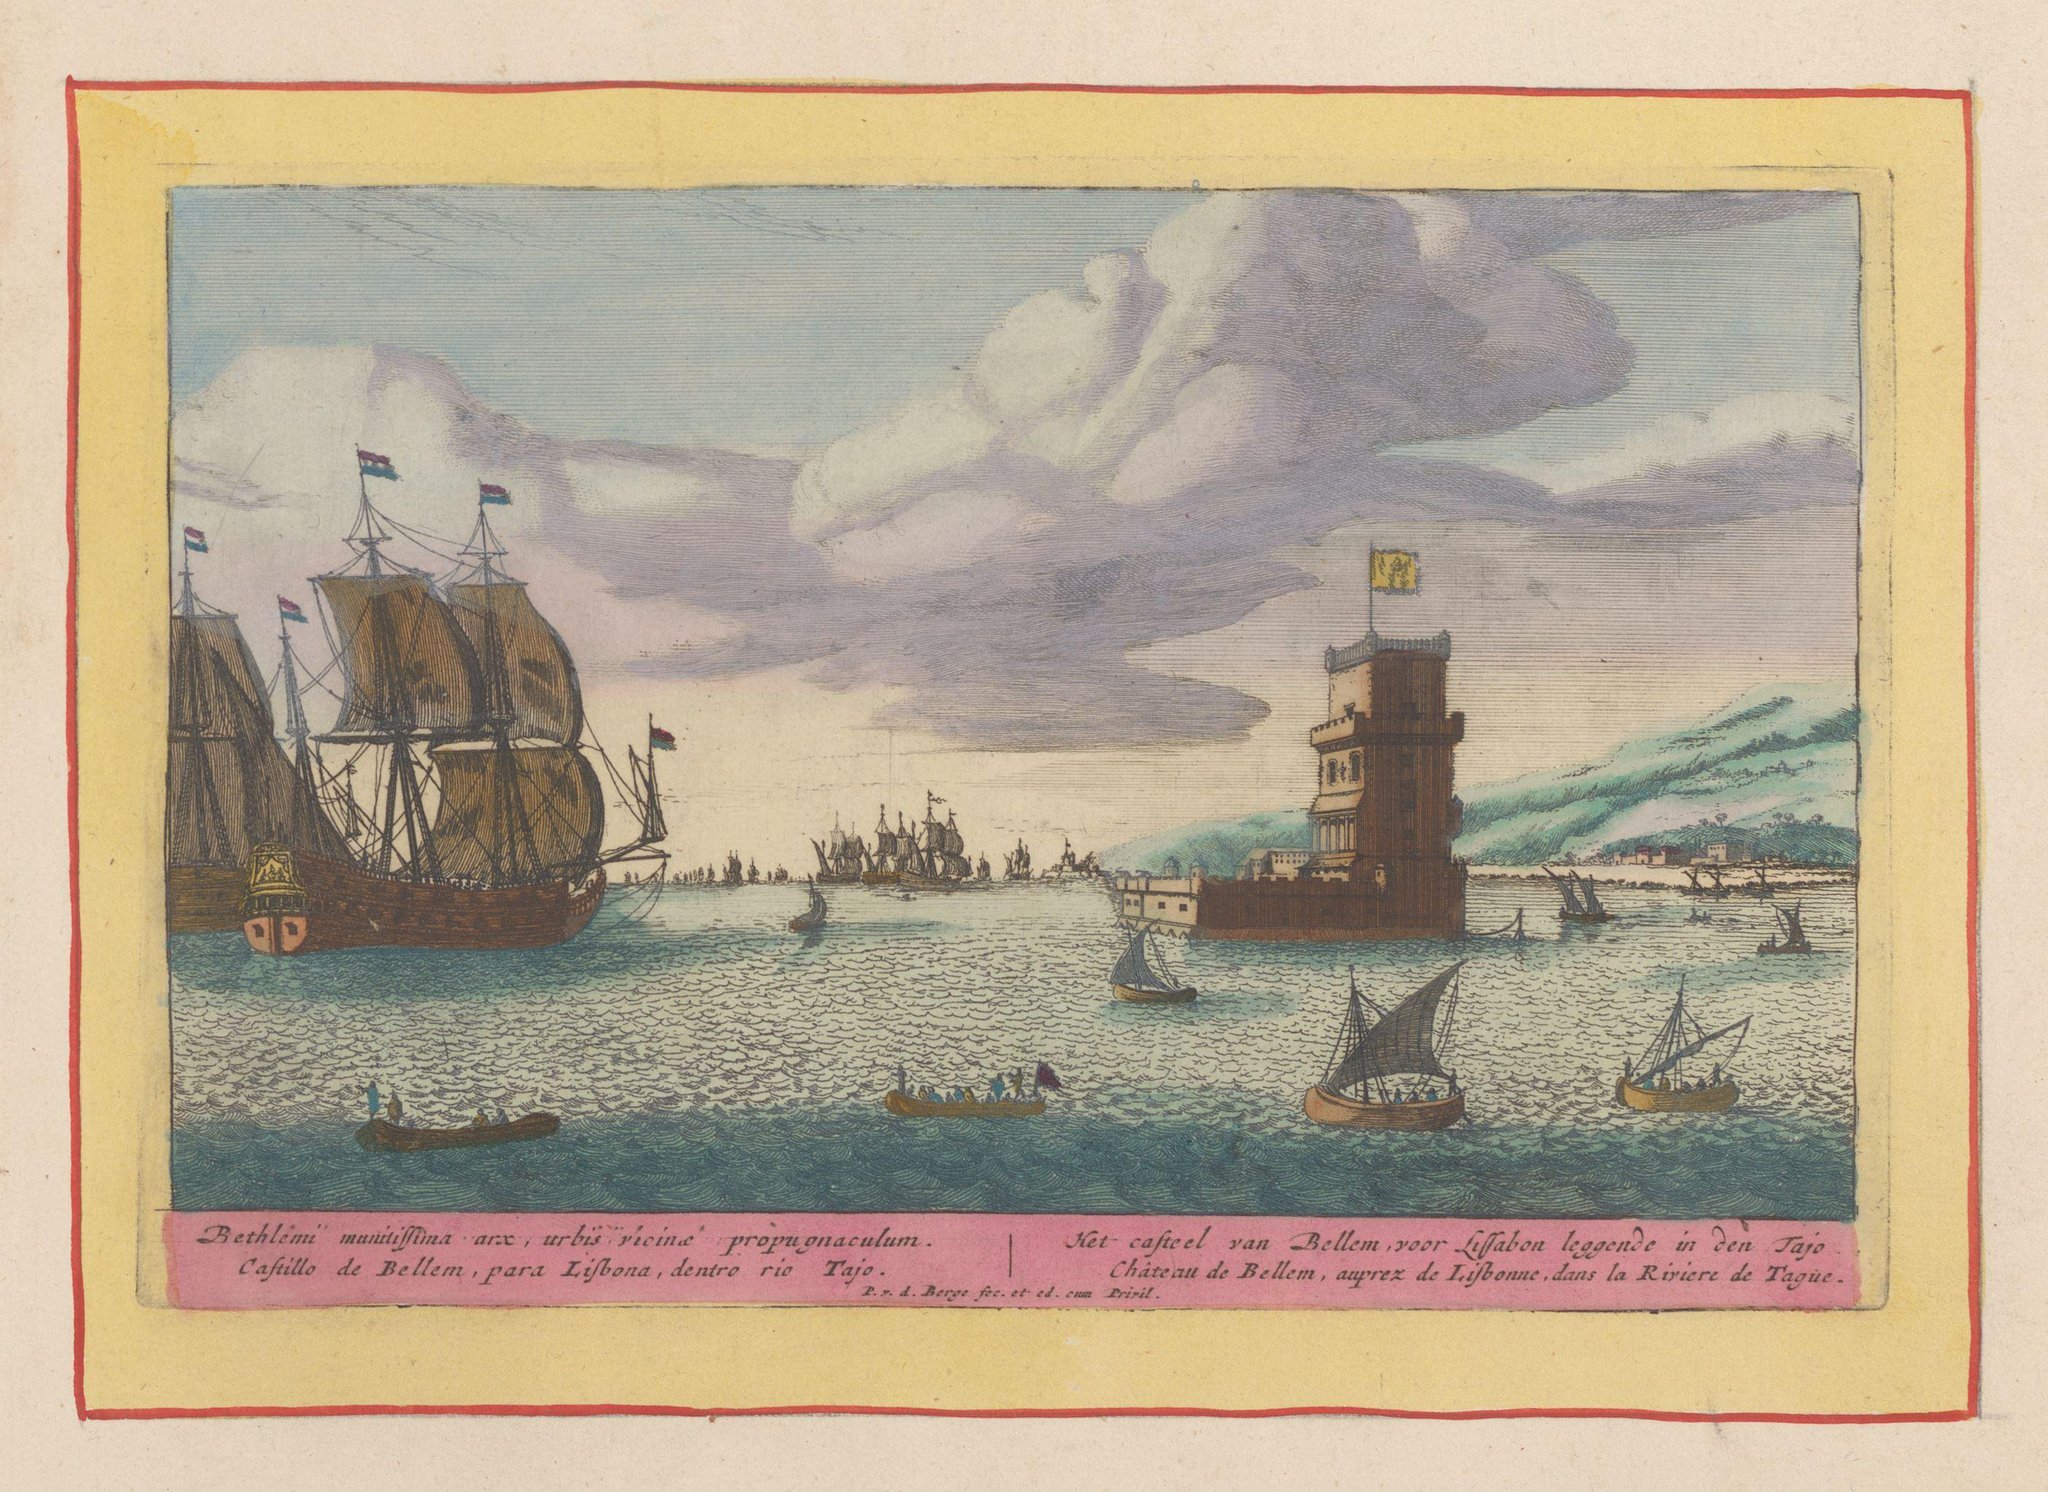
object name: print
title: Theatrum Hispaniae (...)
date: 1694-1737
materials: paper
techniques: etching, hand coloring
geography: amsterdam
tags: castle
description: Gezicht op de toren van Belém in de rivier Taag gelegen. Op de rivier varen schepen en bootjes. Op de toren wappert een vlag. Onder de voorstelling een titel in het Latijn, Spaans, Nederlandsen Frans. Prent maakt deel uit van een album.